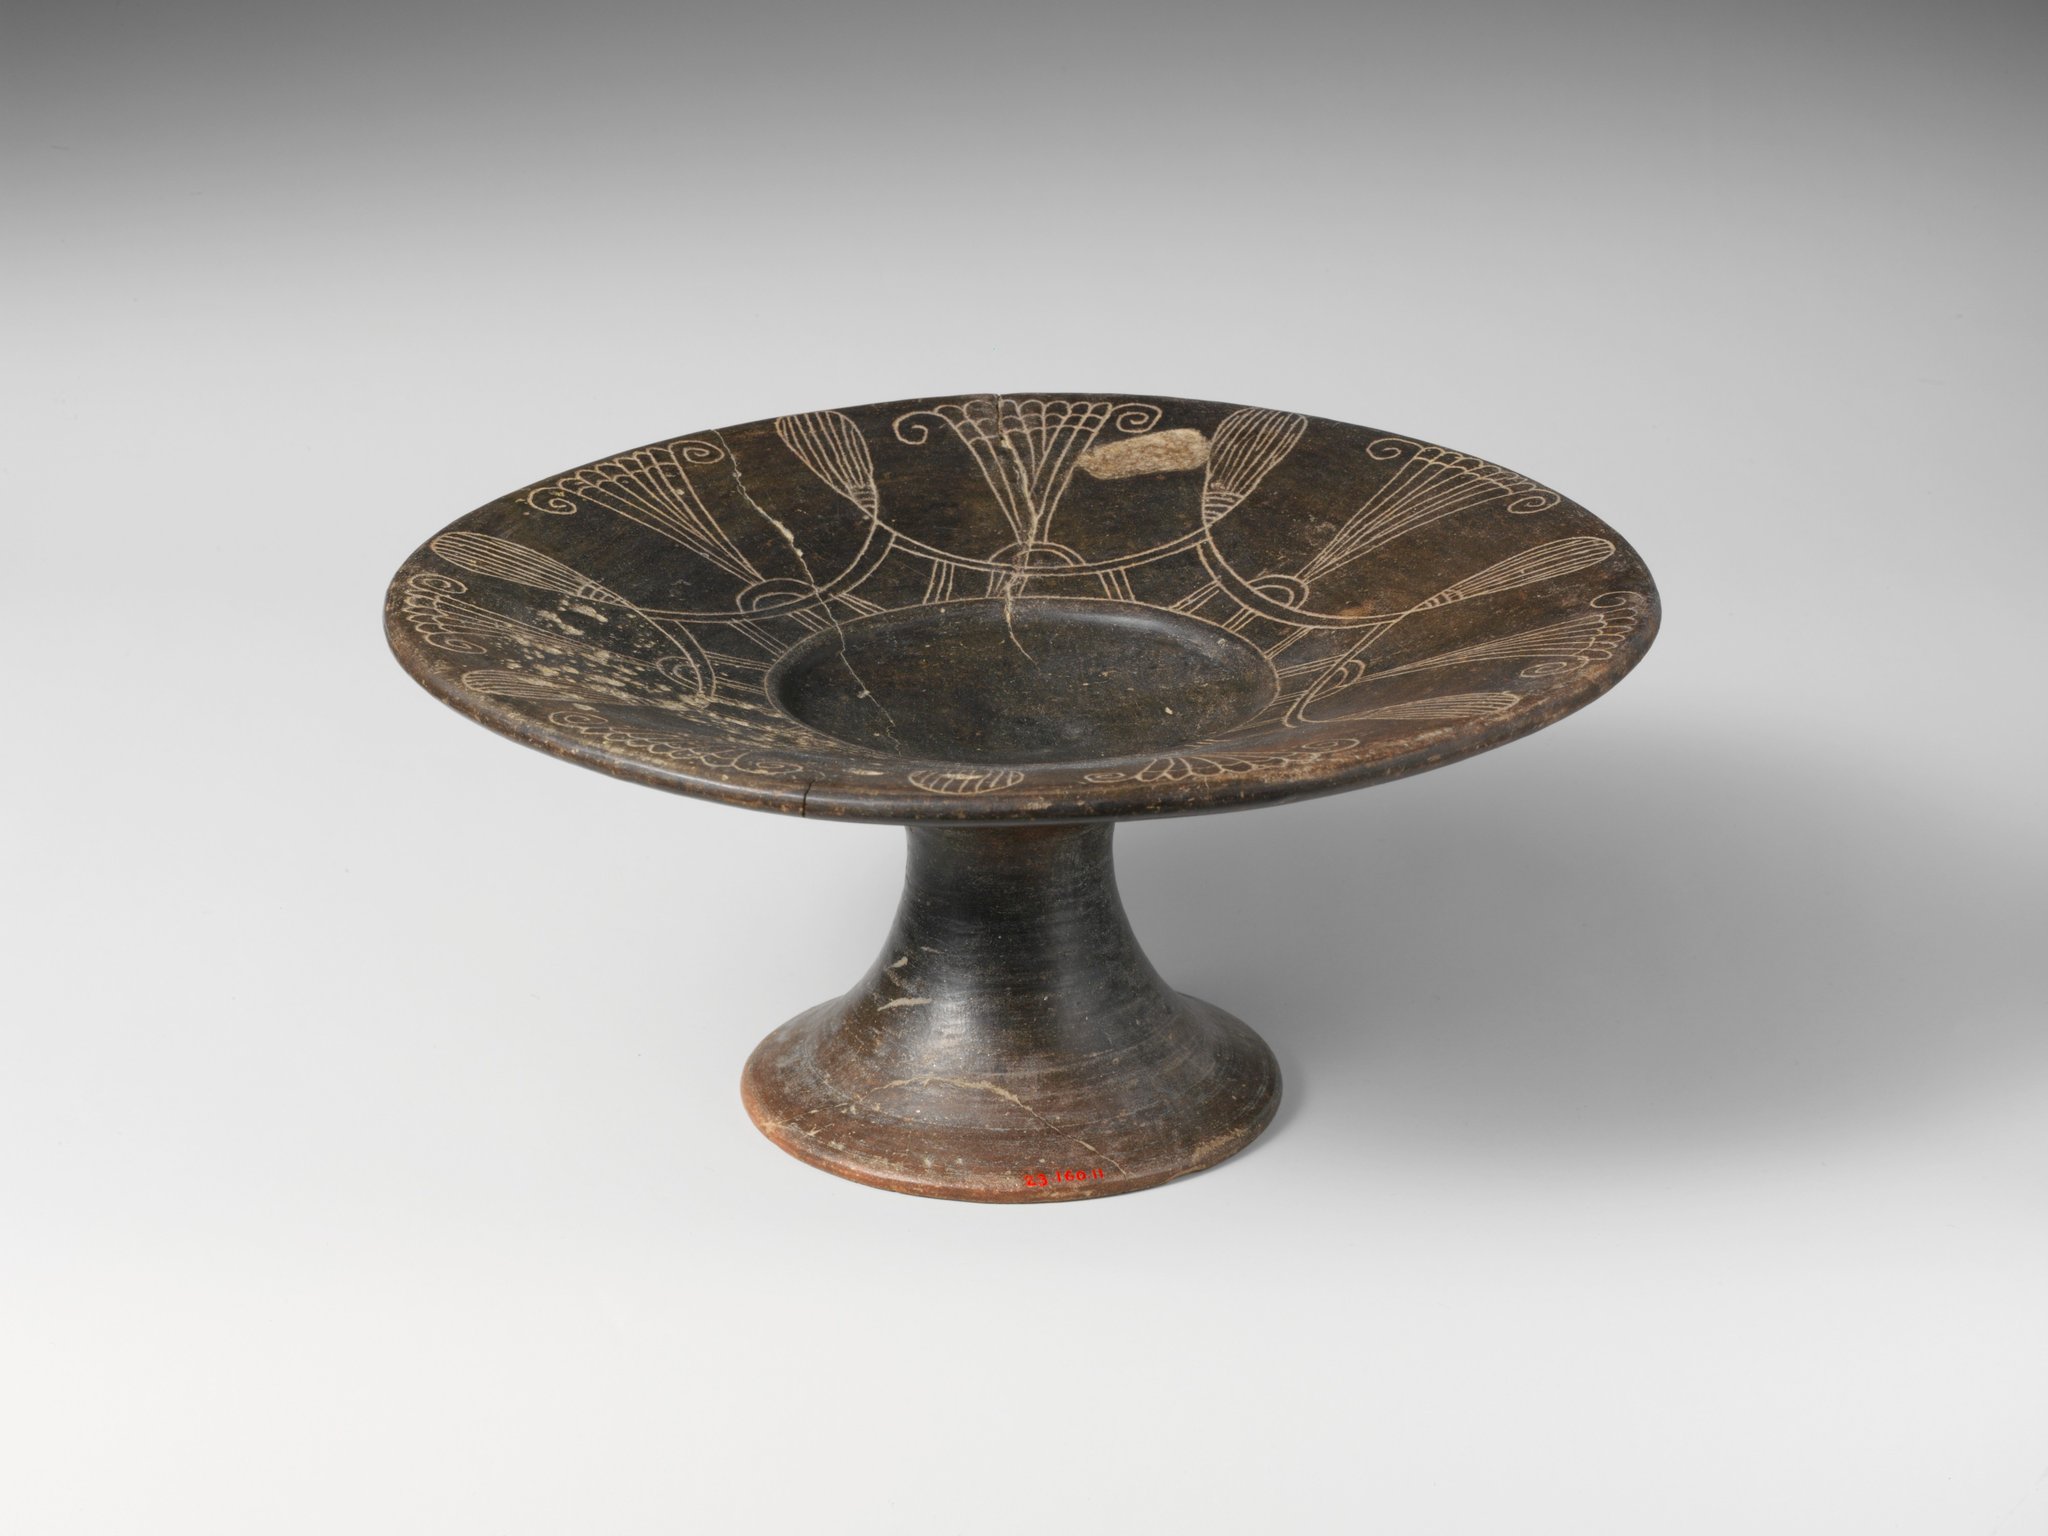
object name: plate, stemmed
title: Terracotta stemmed plate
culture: capenate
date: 625-600 BCE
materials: terracotta